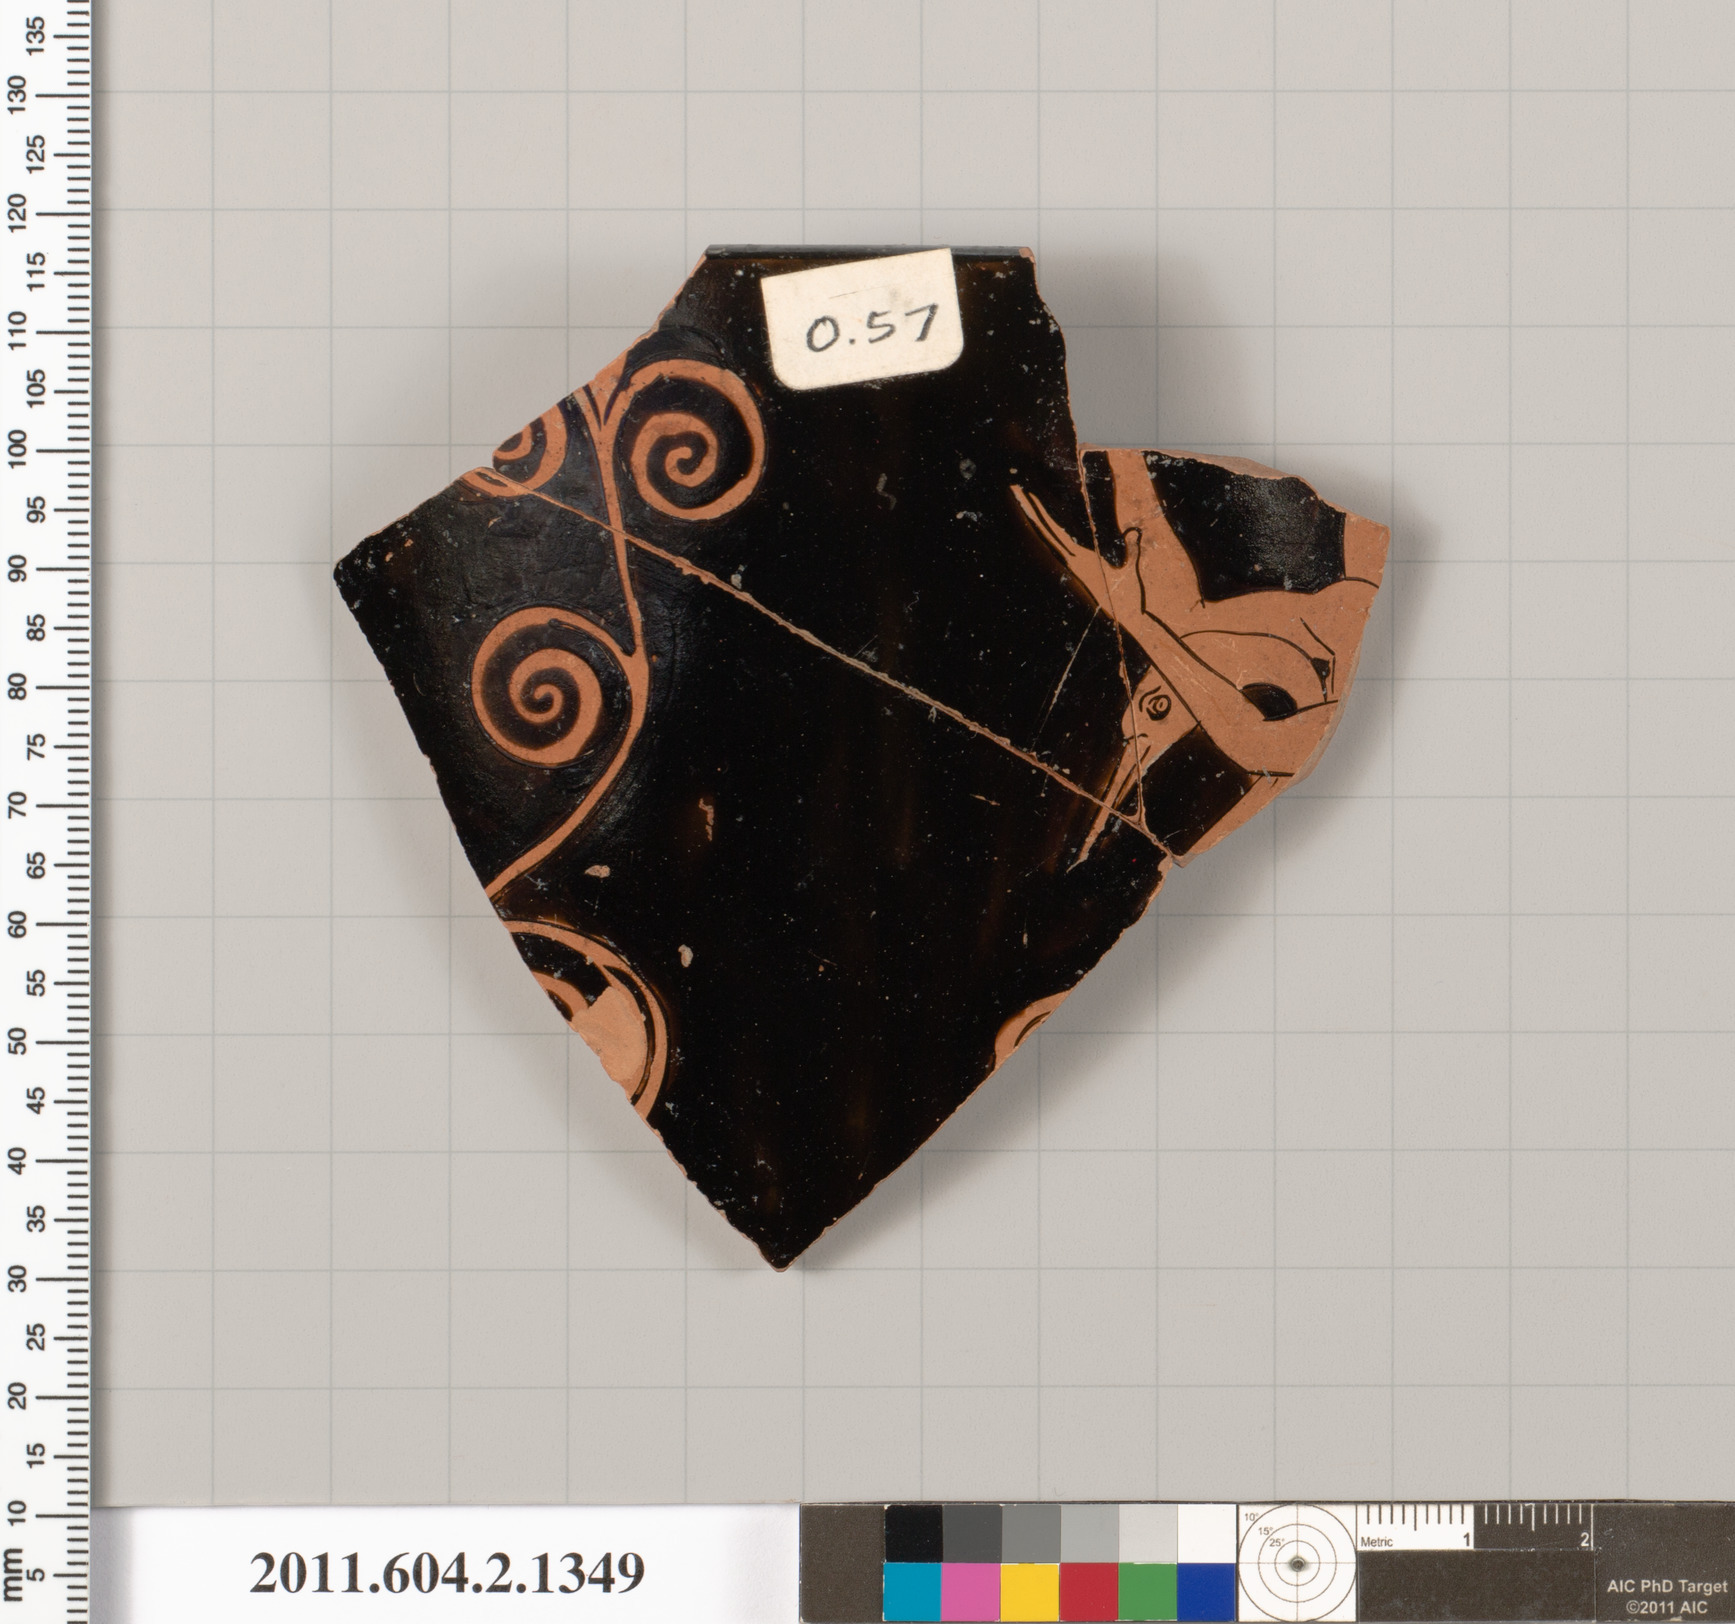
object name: skyphos fragment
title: Terracotta fragment of a skyphos (deep drinking cup)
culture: greek, attic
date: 500-480 BCE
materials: terracotta